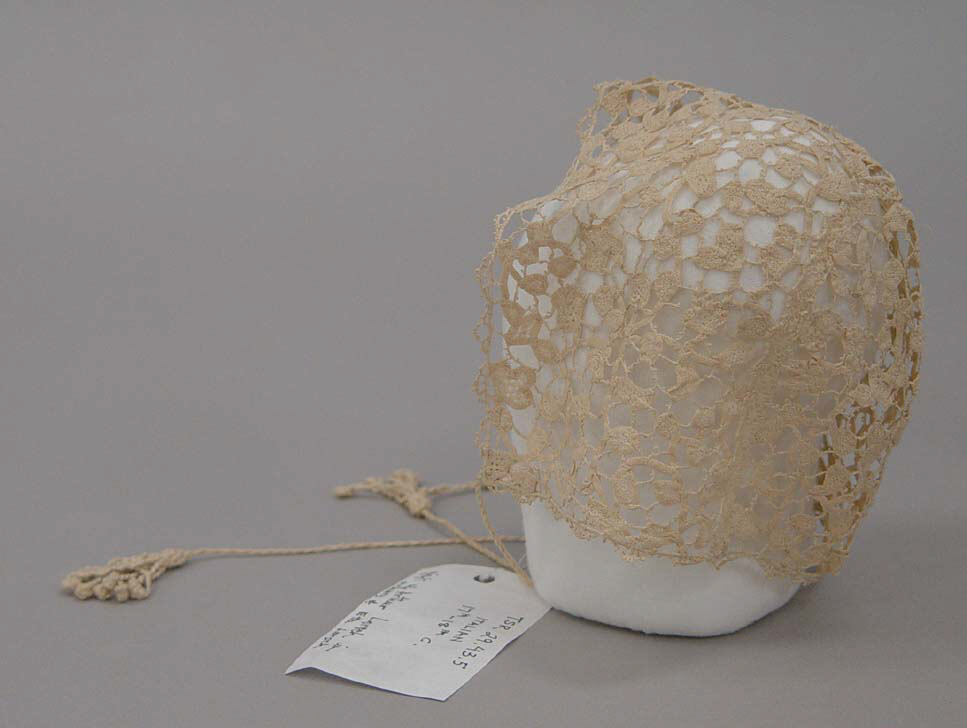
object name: cap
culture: italian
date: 1601-1800